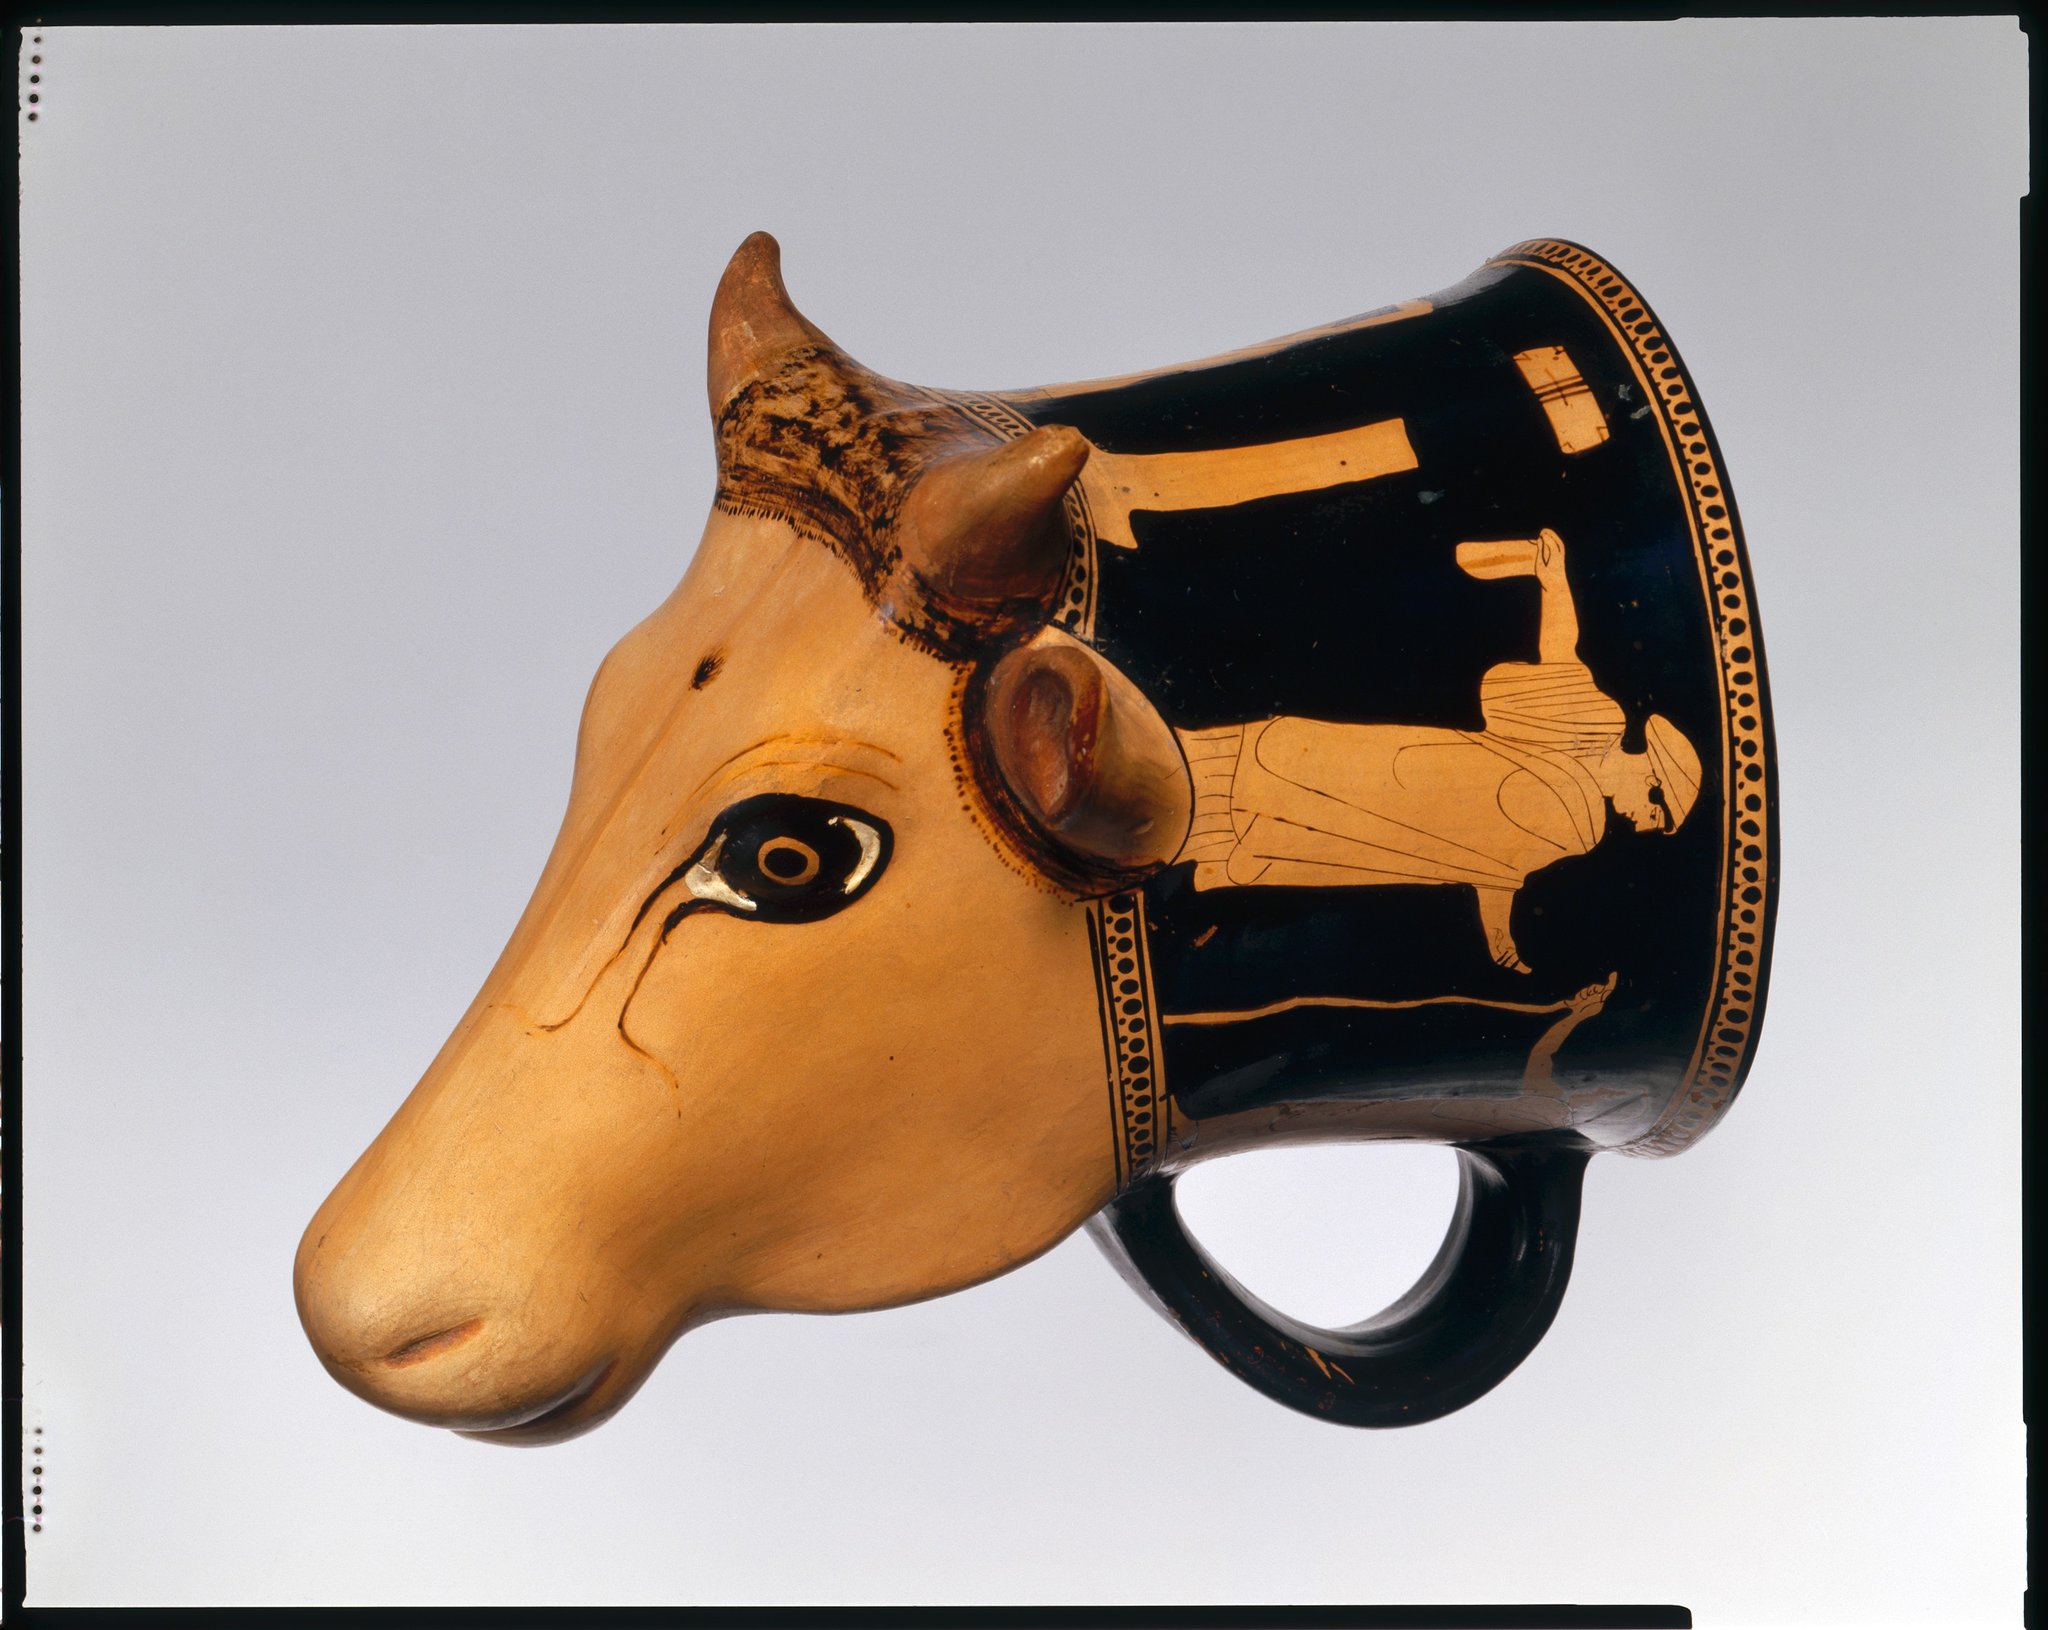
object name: rhyton in the form of a bull's head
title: Terracotta rhyton (vase for libations or drinking)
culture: greek, attic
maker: cow-head group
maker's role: artist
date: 460 BCE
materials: terracotta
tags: women,cows